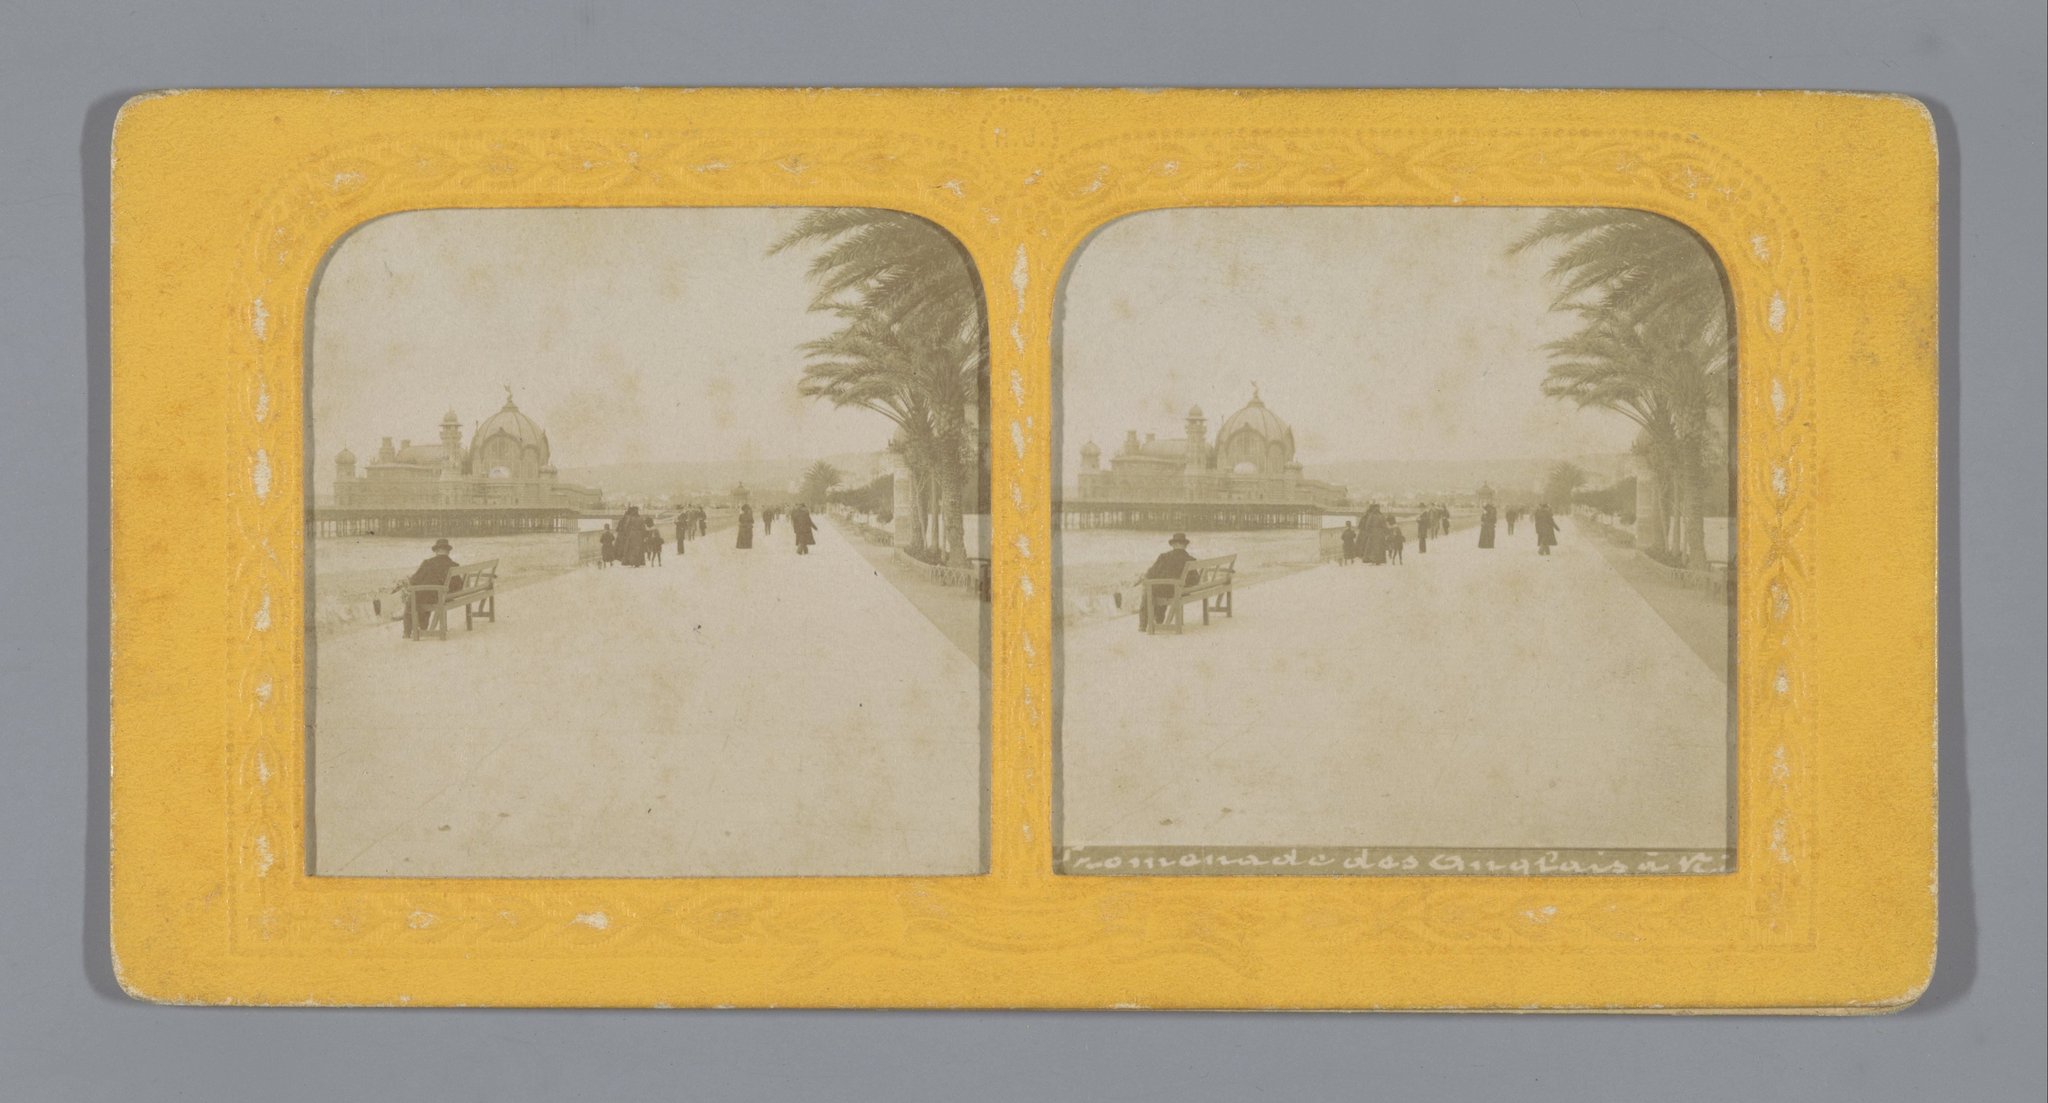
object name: tissue stereograph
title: Promenade des Anglais in Nice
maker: eugène hanau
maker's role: publisher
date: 1903-1904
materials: cardboard, paper, photographic support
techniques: albumen print, hand coloring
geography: nice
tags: trees: palm-tree, avenue, boulevard, promenade, esplanade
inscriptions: monogram: ‘H.J.’, number: ‘25’